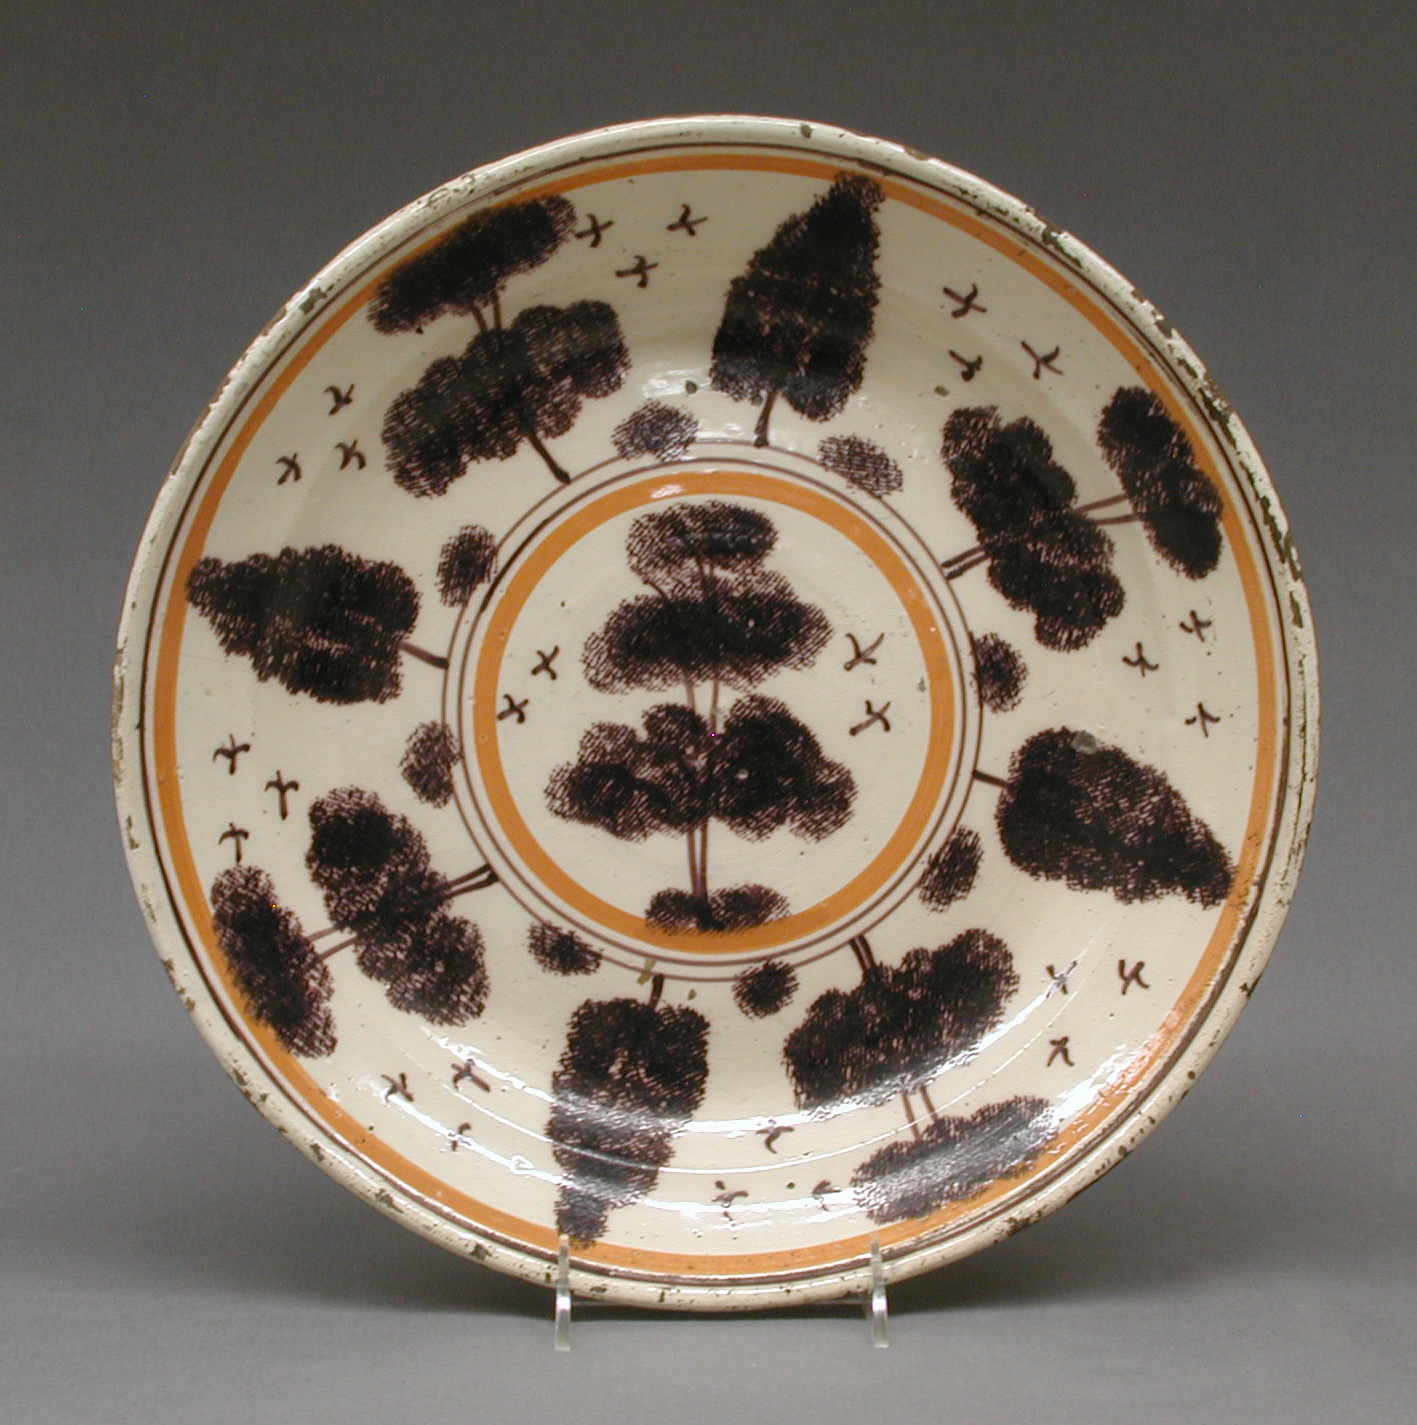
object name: dish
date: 1801-1825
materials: earthenware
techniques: enamel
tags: trees